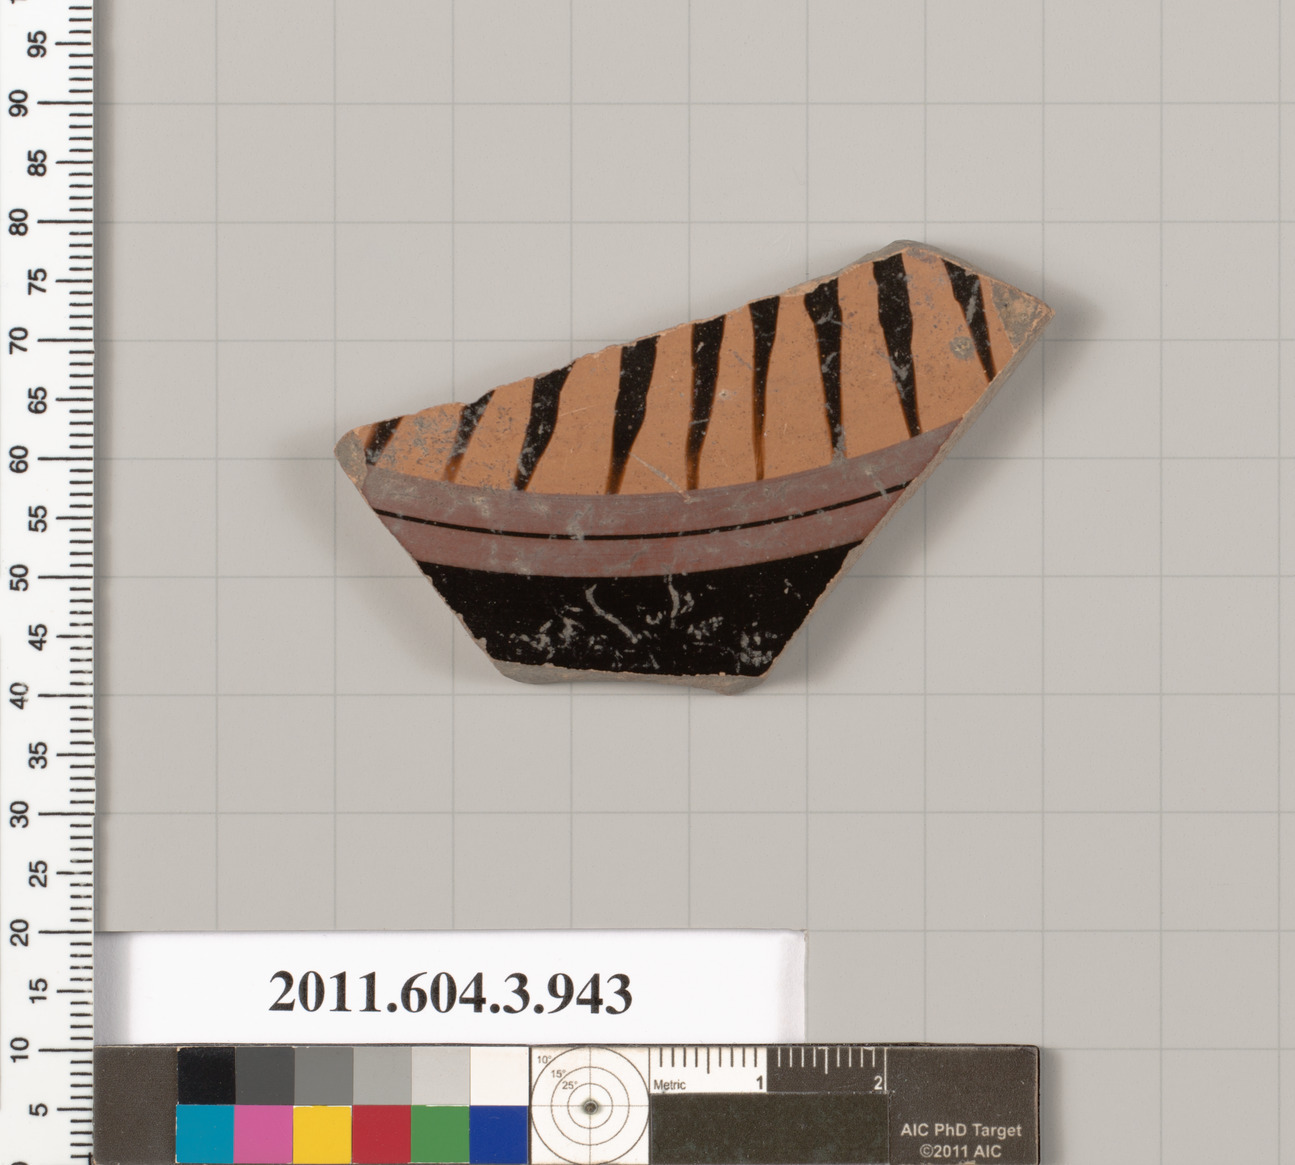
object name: lekanis lid fragment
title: Terracotta fragment of a lekanis lid (covered dish)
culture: greek, attic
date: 600-501 BCE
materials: terracotta